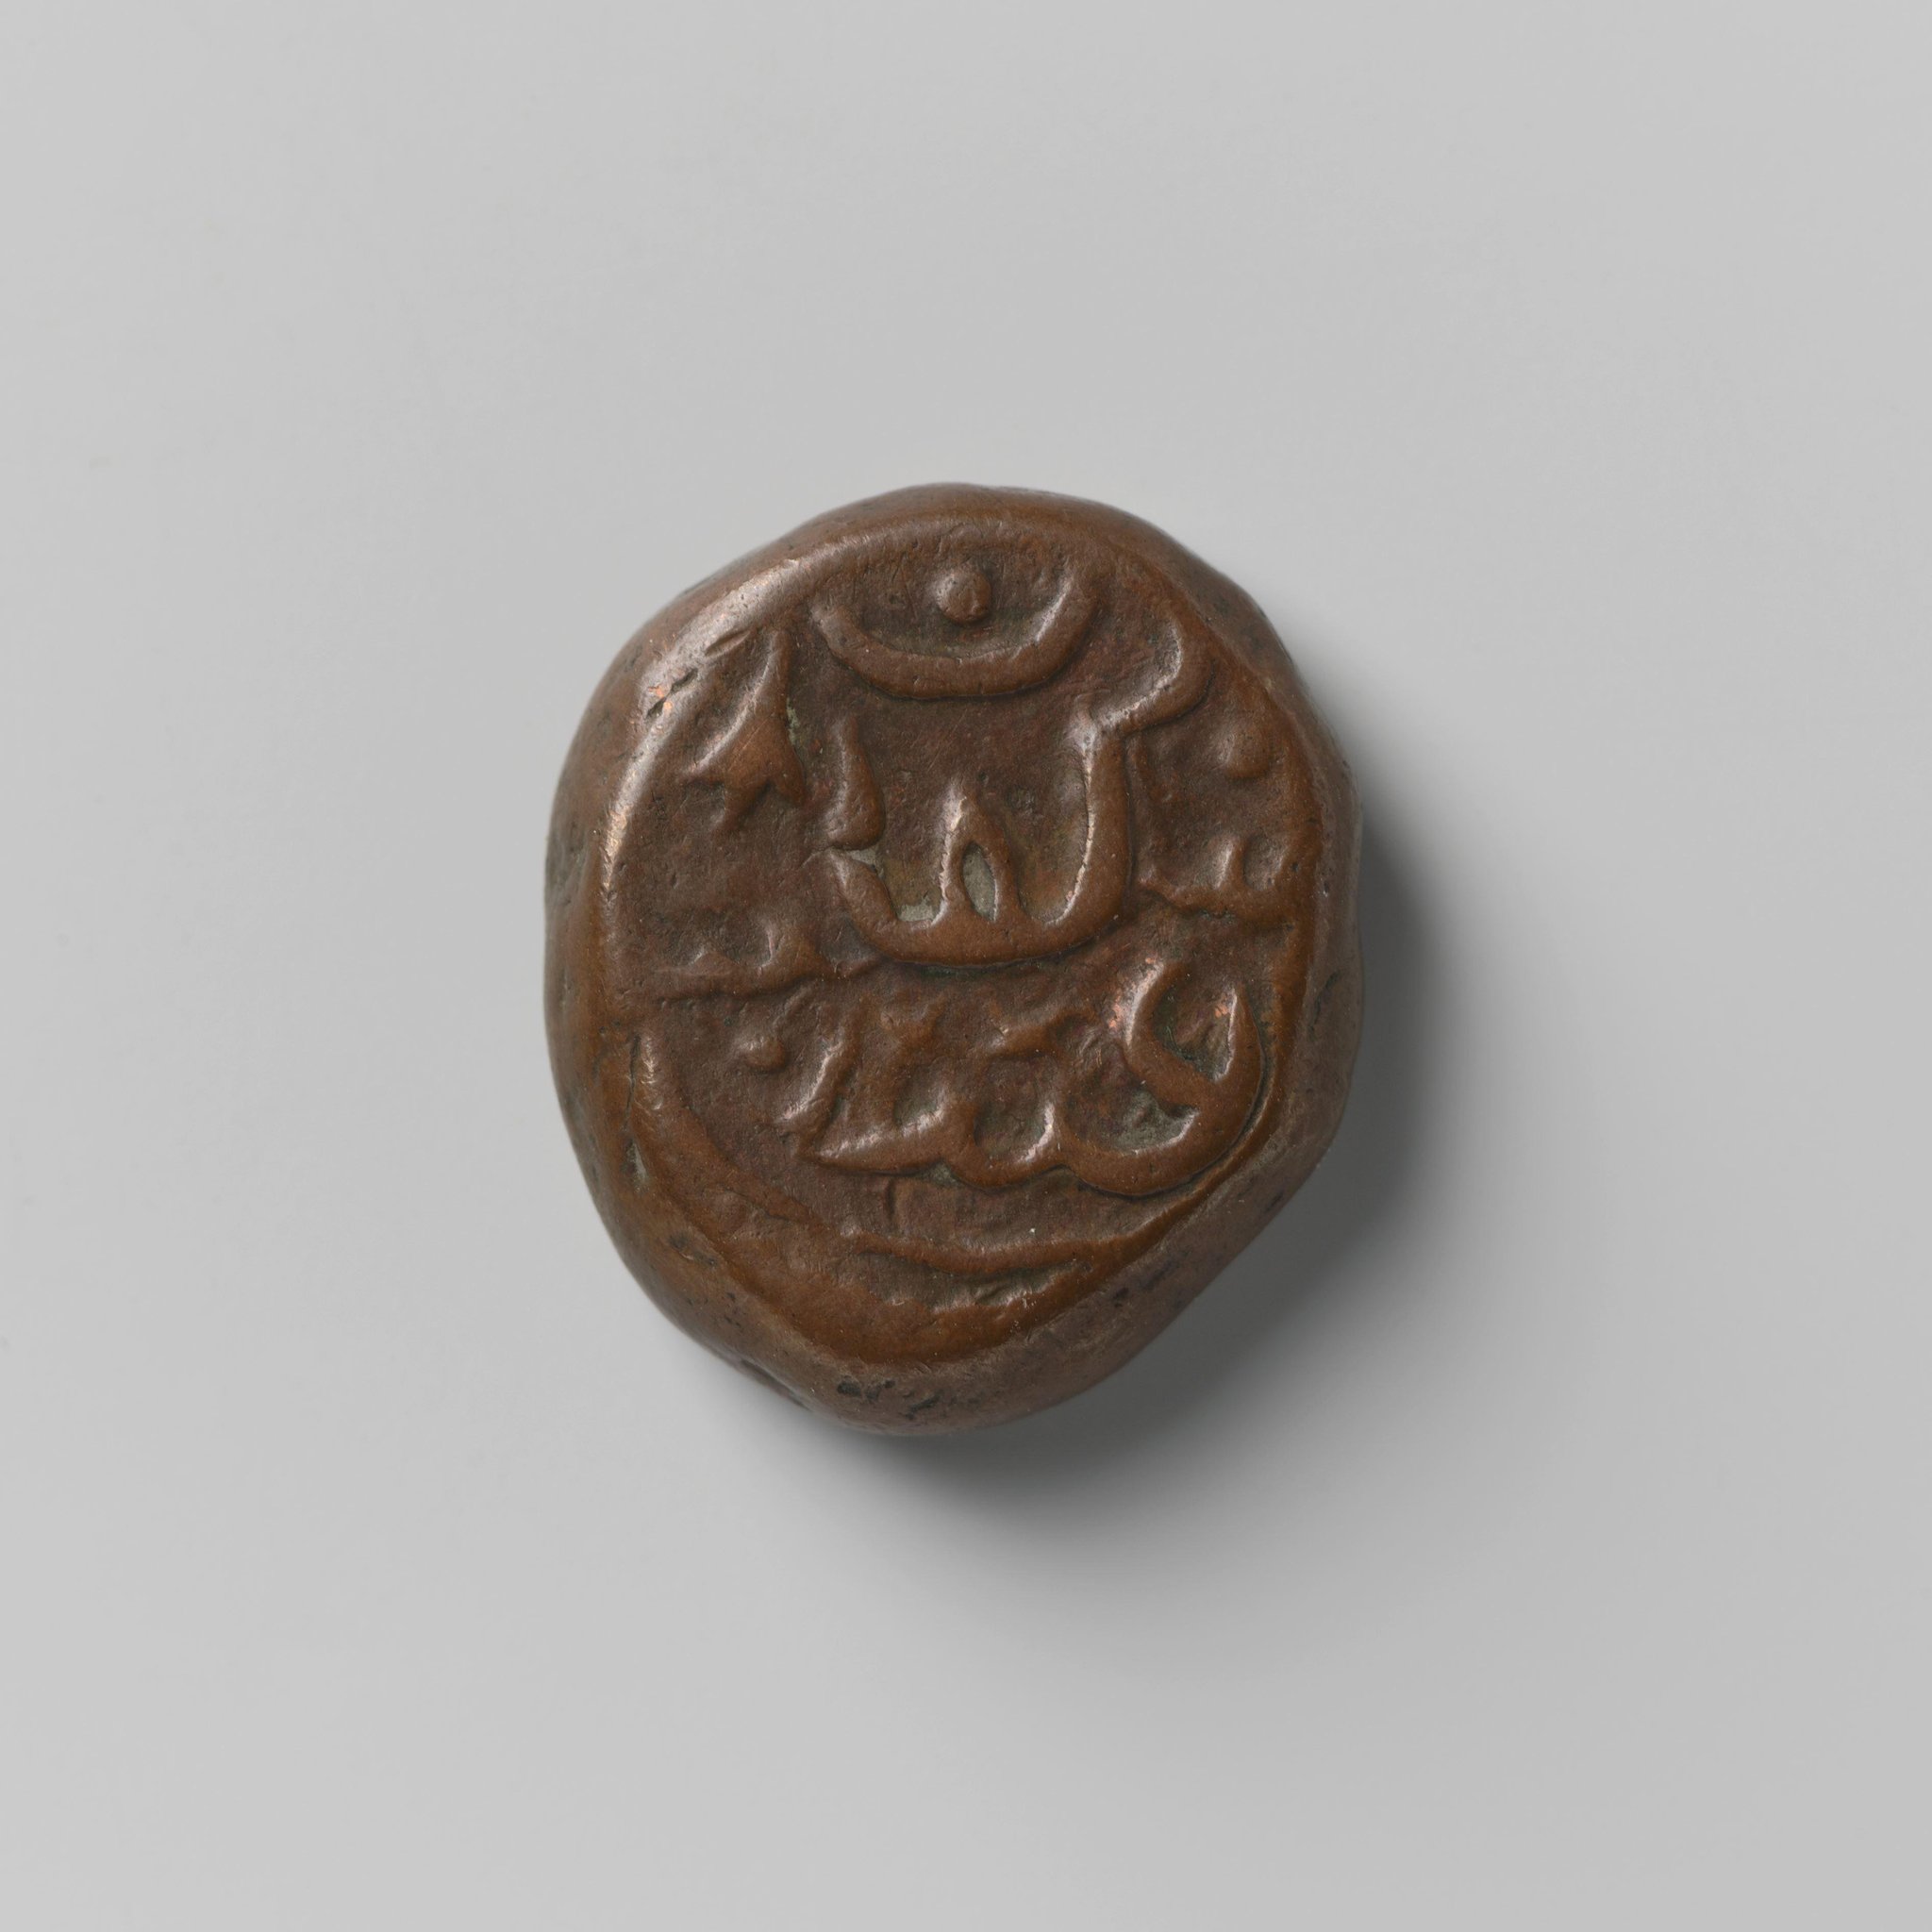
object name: coin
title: 5 kas of ½ stuiver van de VOC van Paliakate voor Ceylon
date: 1650-1700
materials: copper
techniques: striking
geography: paliacatta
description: Koperen munt. Voorzijde: monogram van de VOC, waarboven waarde-aanduiding V. Keerzijde: drieregelig opschrift in Arabische lettertekens. Gladde rand.